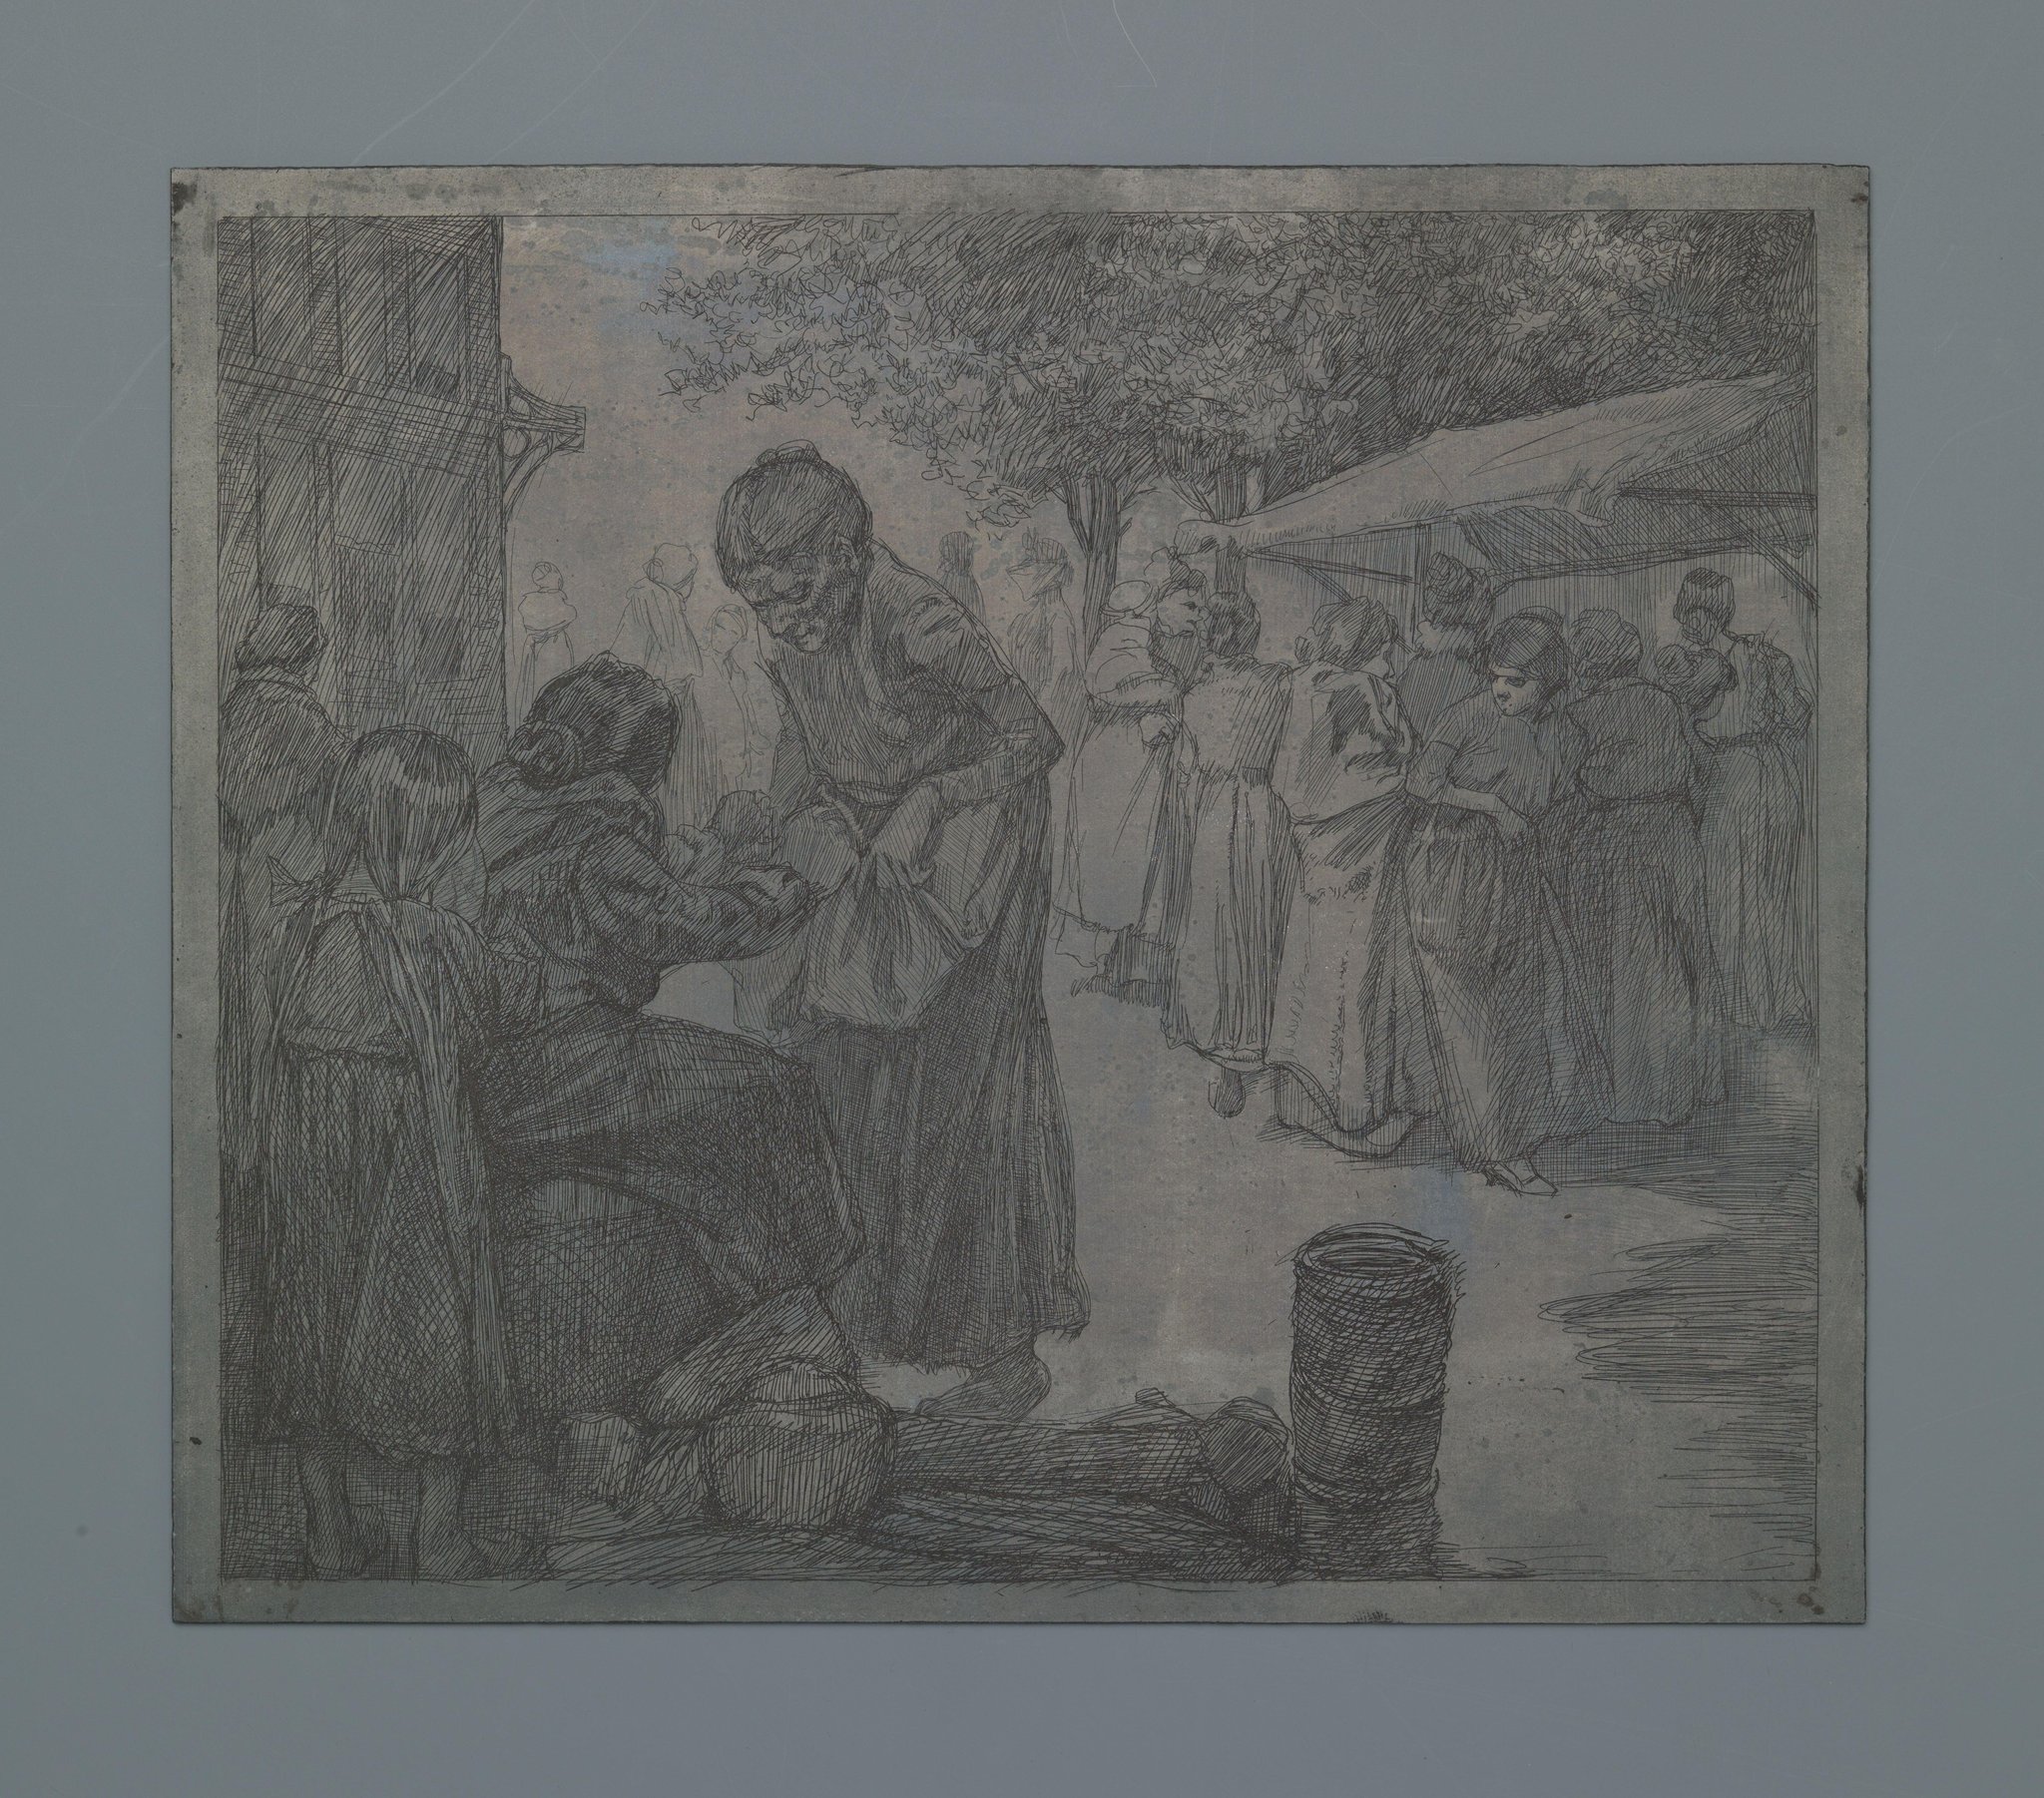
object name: zinkplaat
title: Vrouwen op straat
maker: johannes josephus aarts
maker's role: draughtsman, print maker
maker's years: 1871-1934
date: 1881-1934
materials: zinc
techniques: etching